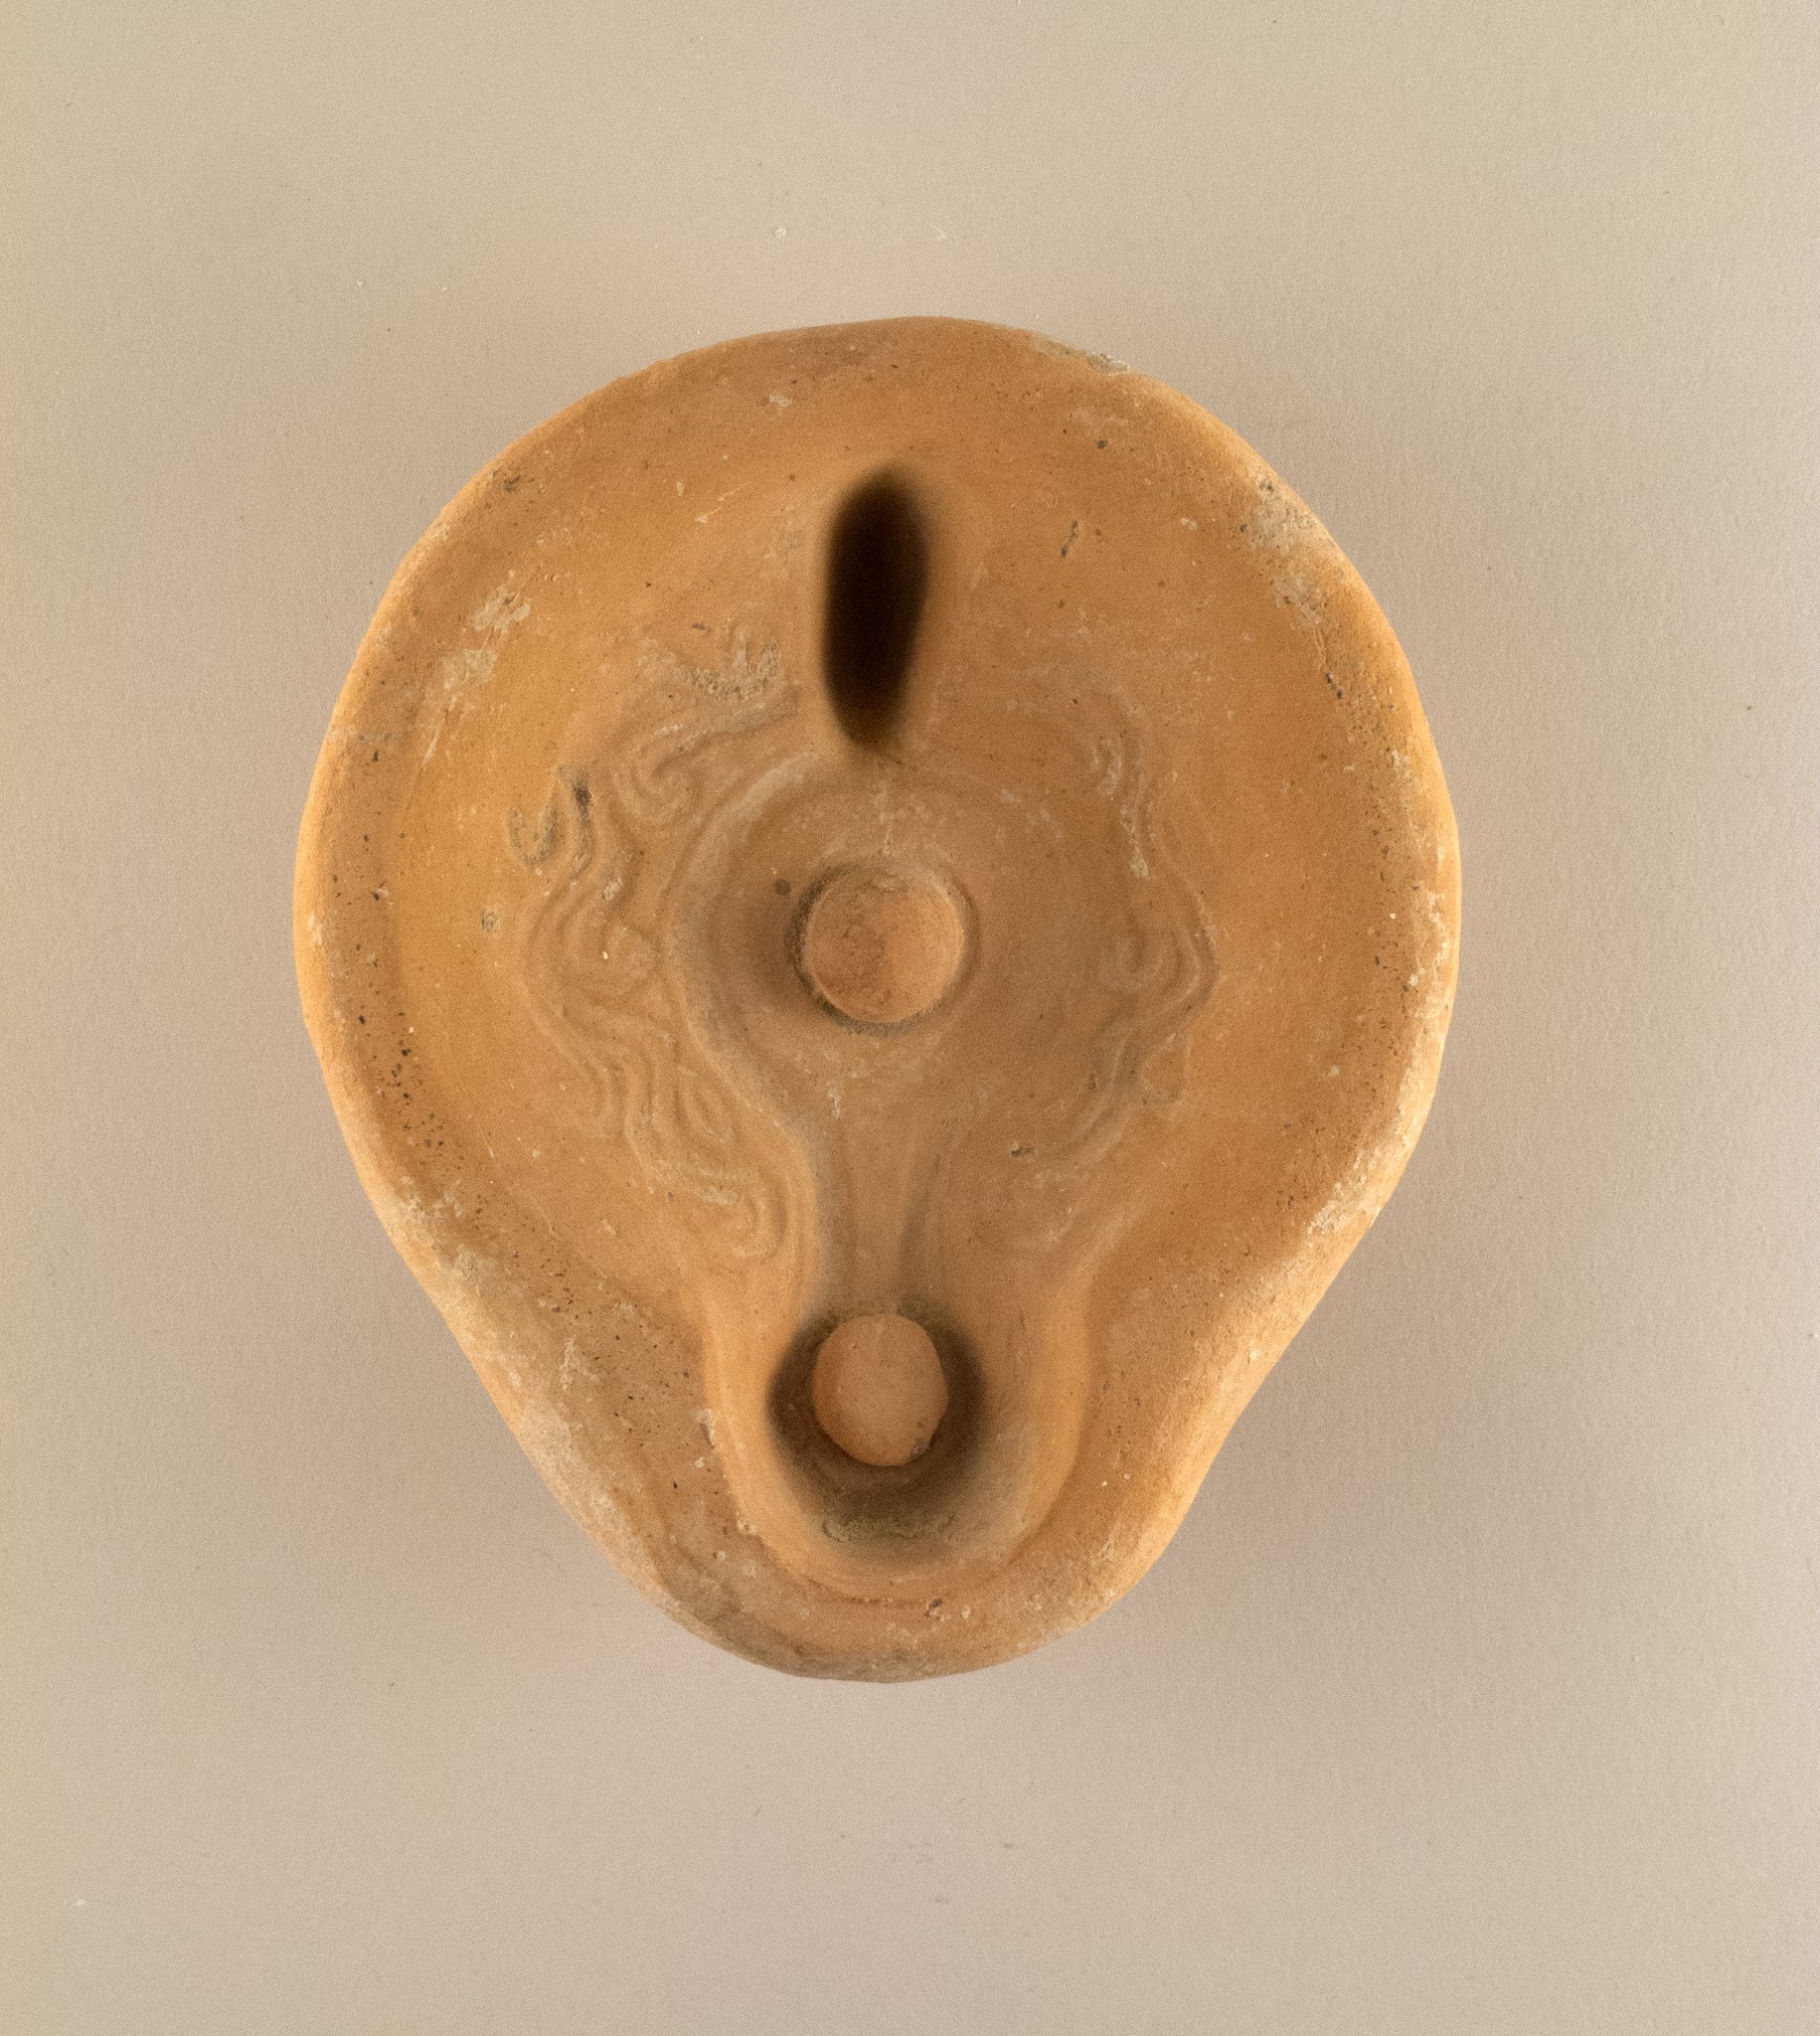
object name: lamp mold, top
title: Terracotta lamp mold, top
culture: roman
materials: terracotta